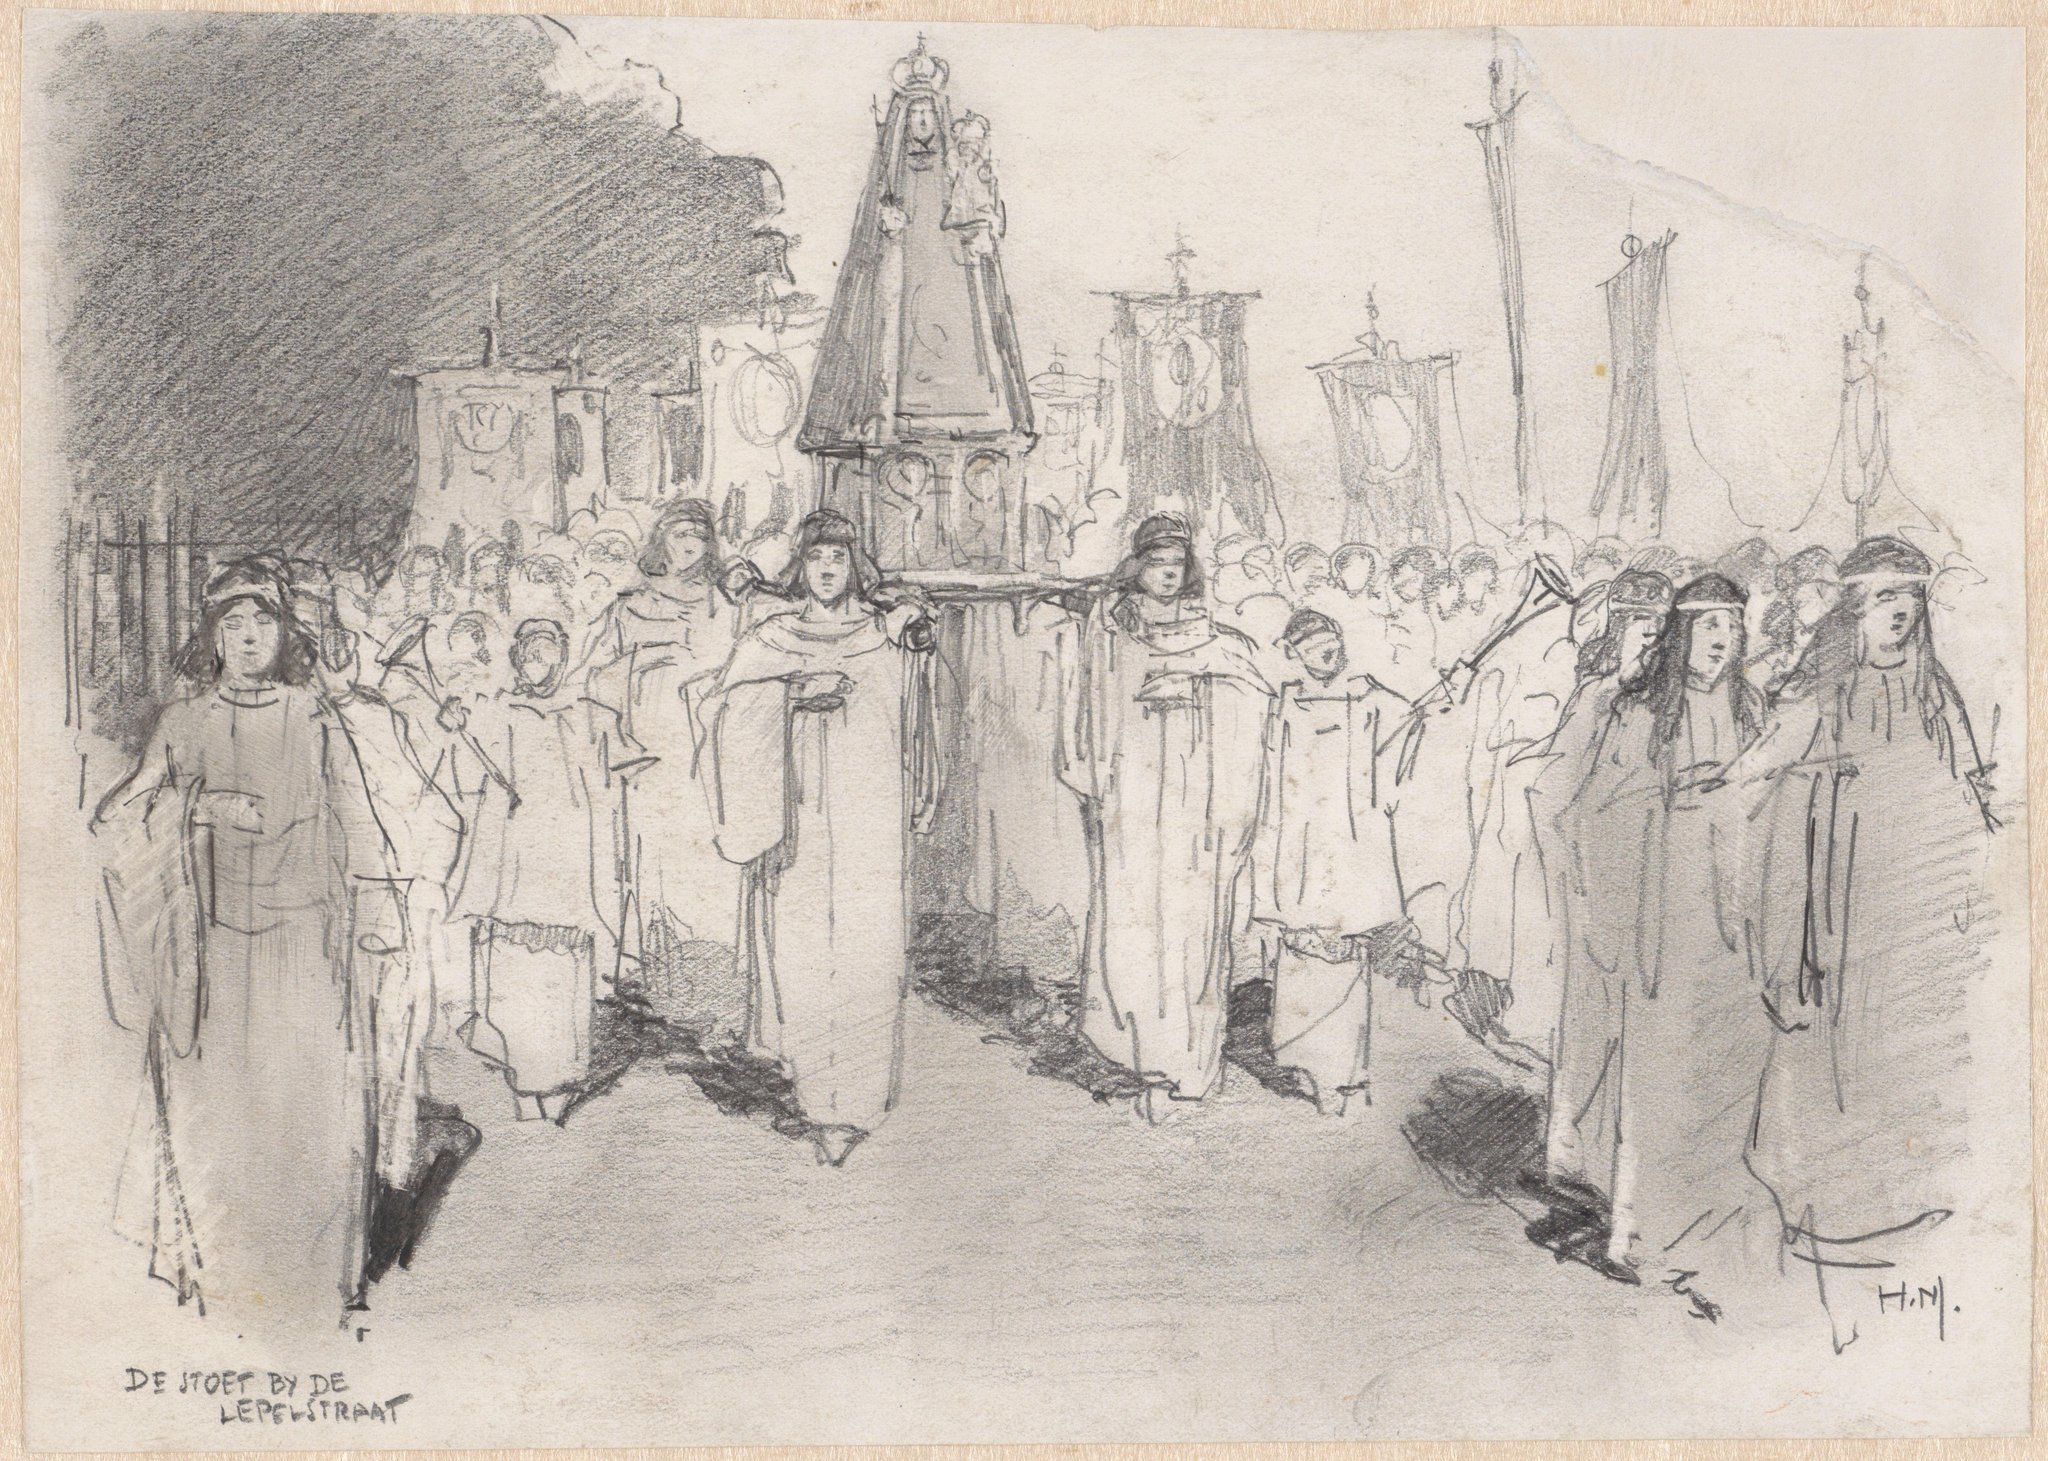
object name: drawing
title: Ommegang van de Zoete Lieve Vrouw van Den Bosch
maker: herman moerkerk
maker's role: draughtsman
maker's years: 1879-1949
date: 1889-1944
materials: paper, pencil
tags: procession ~ christian religion, den bosch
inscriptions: annotation: ‘De stoet bij de Lepelstraat’